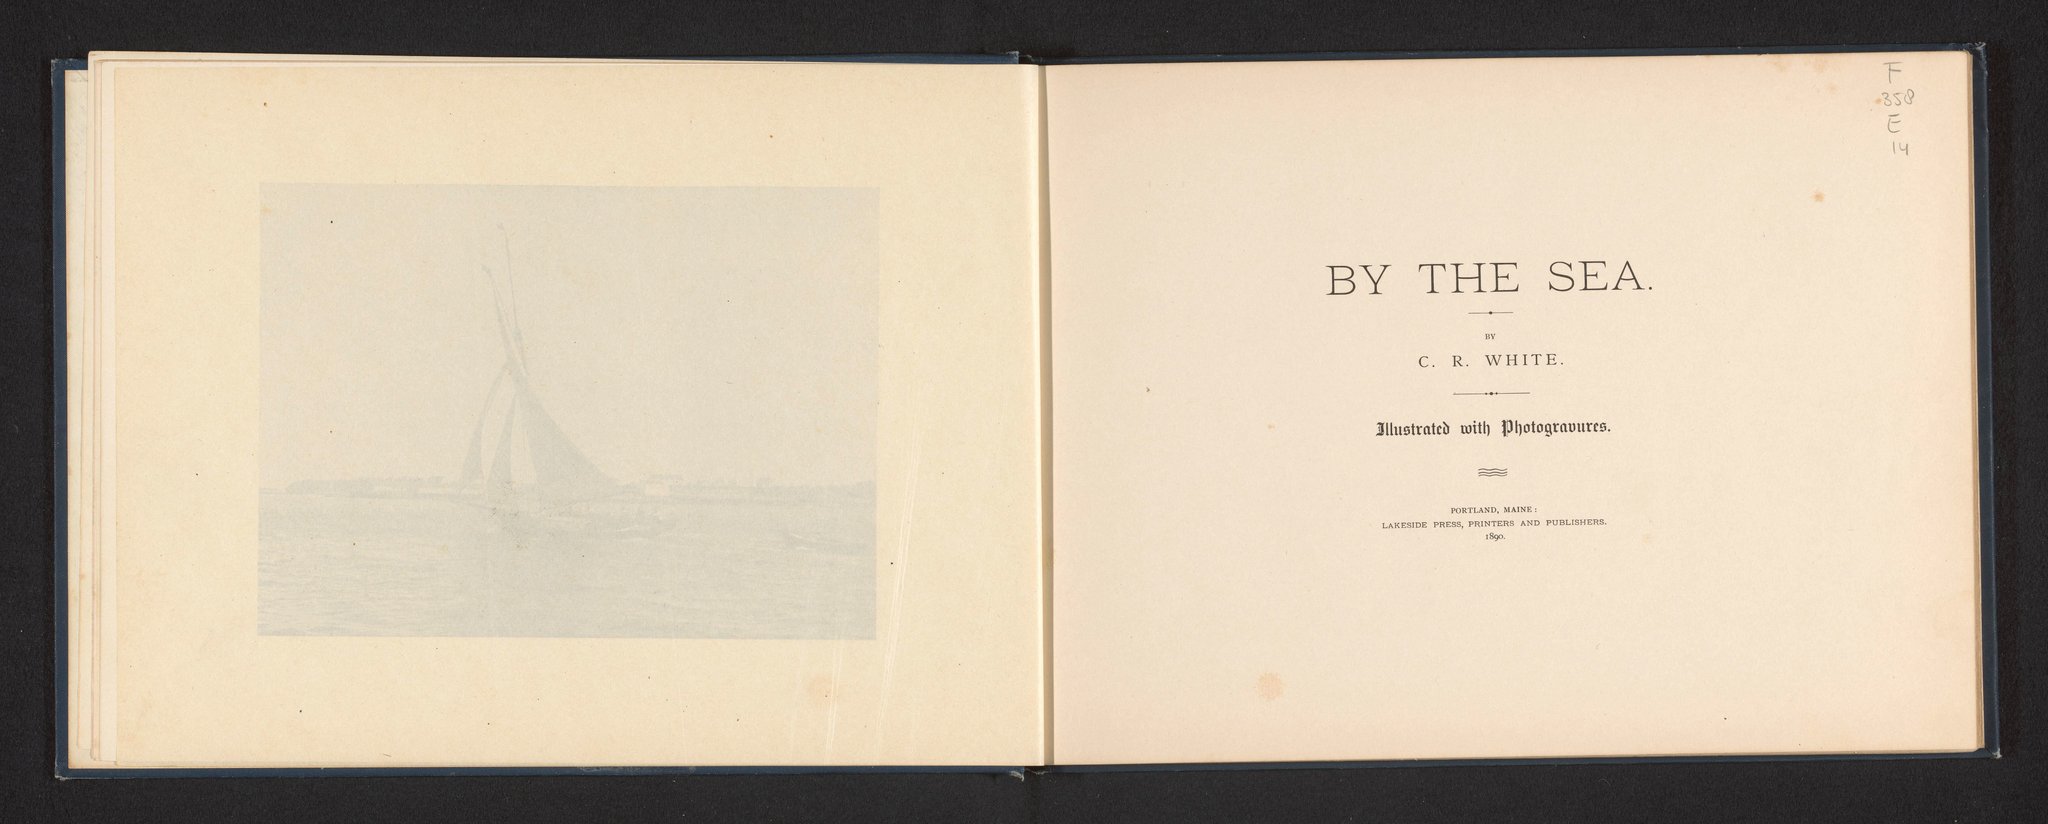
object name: book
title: By the sea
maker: c.r. white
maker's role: auteur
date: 1890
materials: cardboard, linen, paper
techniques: photoaquatint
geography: portland